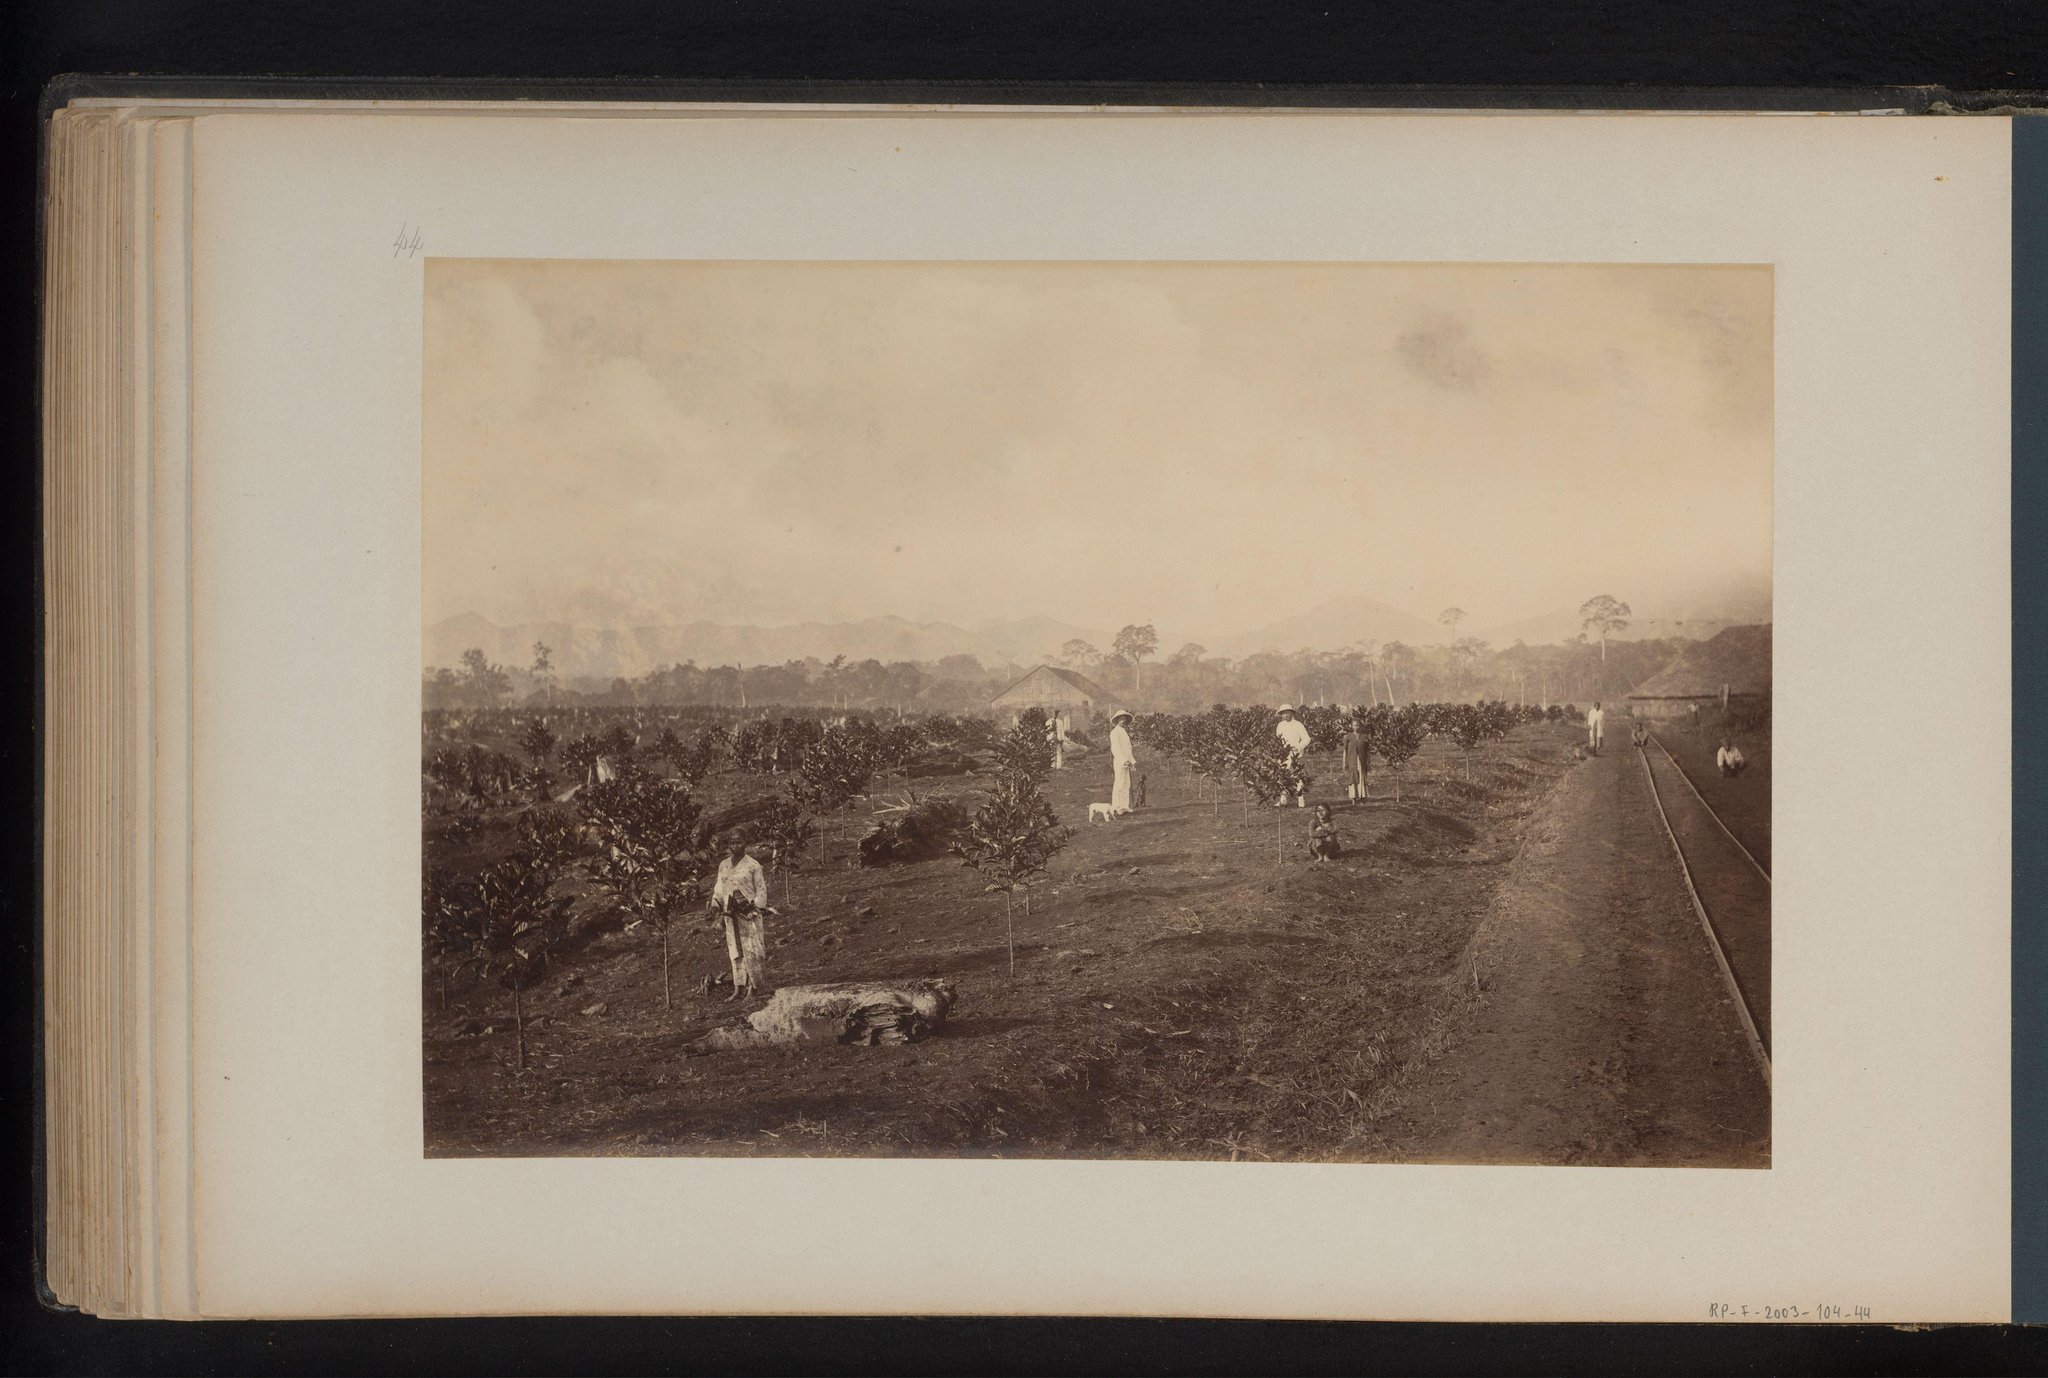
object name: album leaf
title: Gezicht op de koffieplantage Blaukakan, Sumatra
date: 1890-1900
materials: cardboard, photographic support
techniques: albumen print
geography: sumatra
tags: plantation, coffee, sumatra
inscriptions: number: ‘44’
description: In de lijst van afbeeldingen wordt deze foto beschreven met de woorden "Kaffeepflanzung 'Blaukakan'".